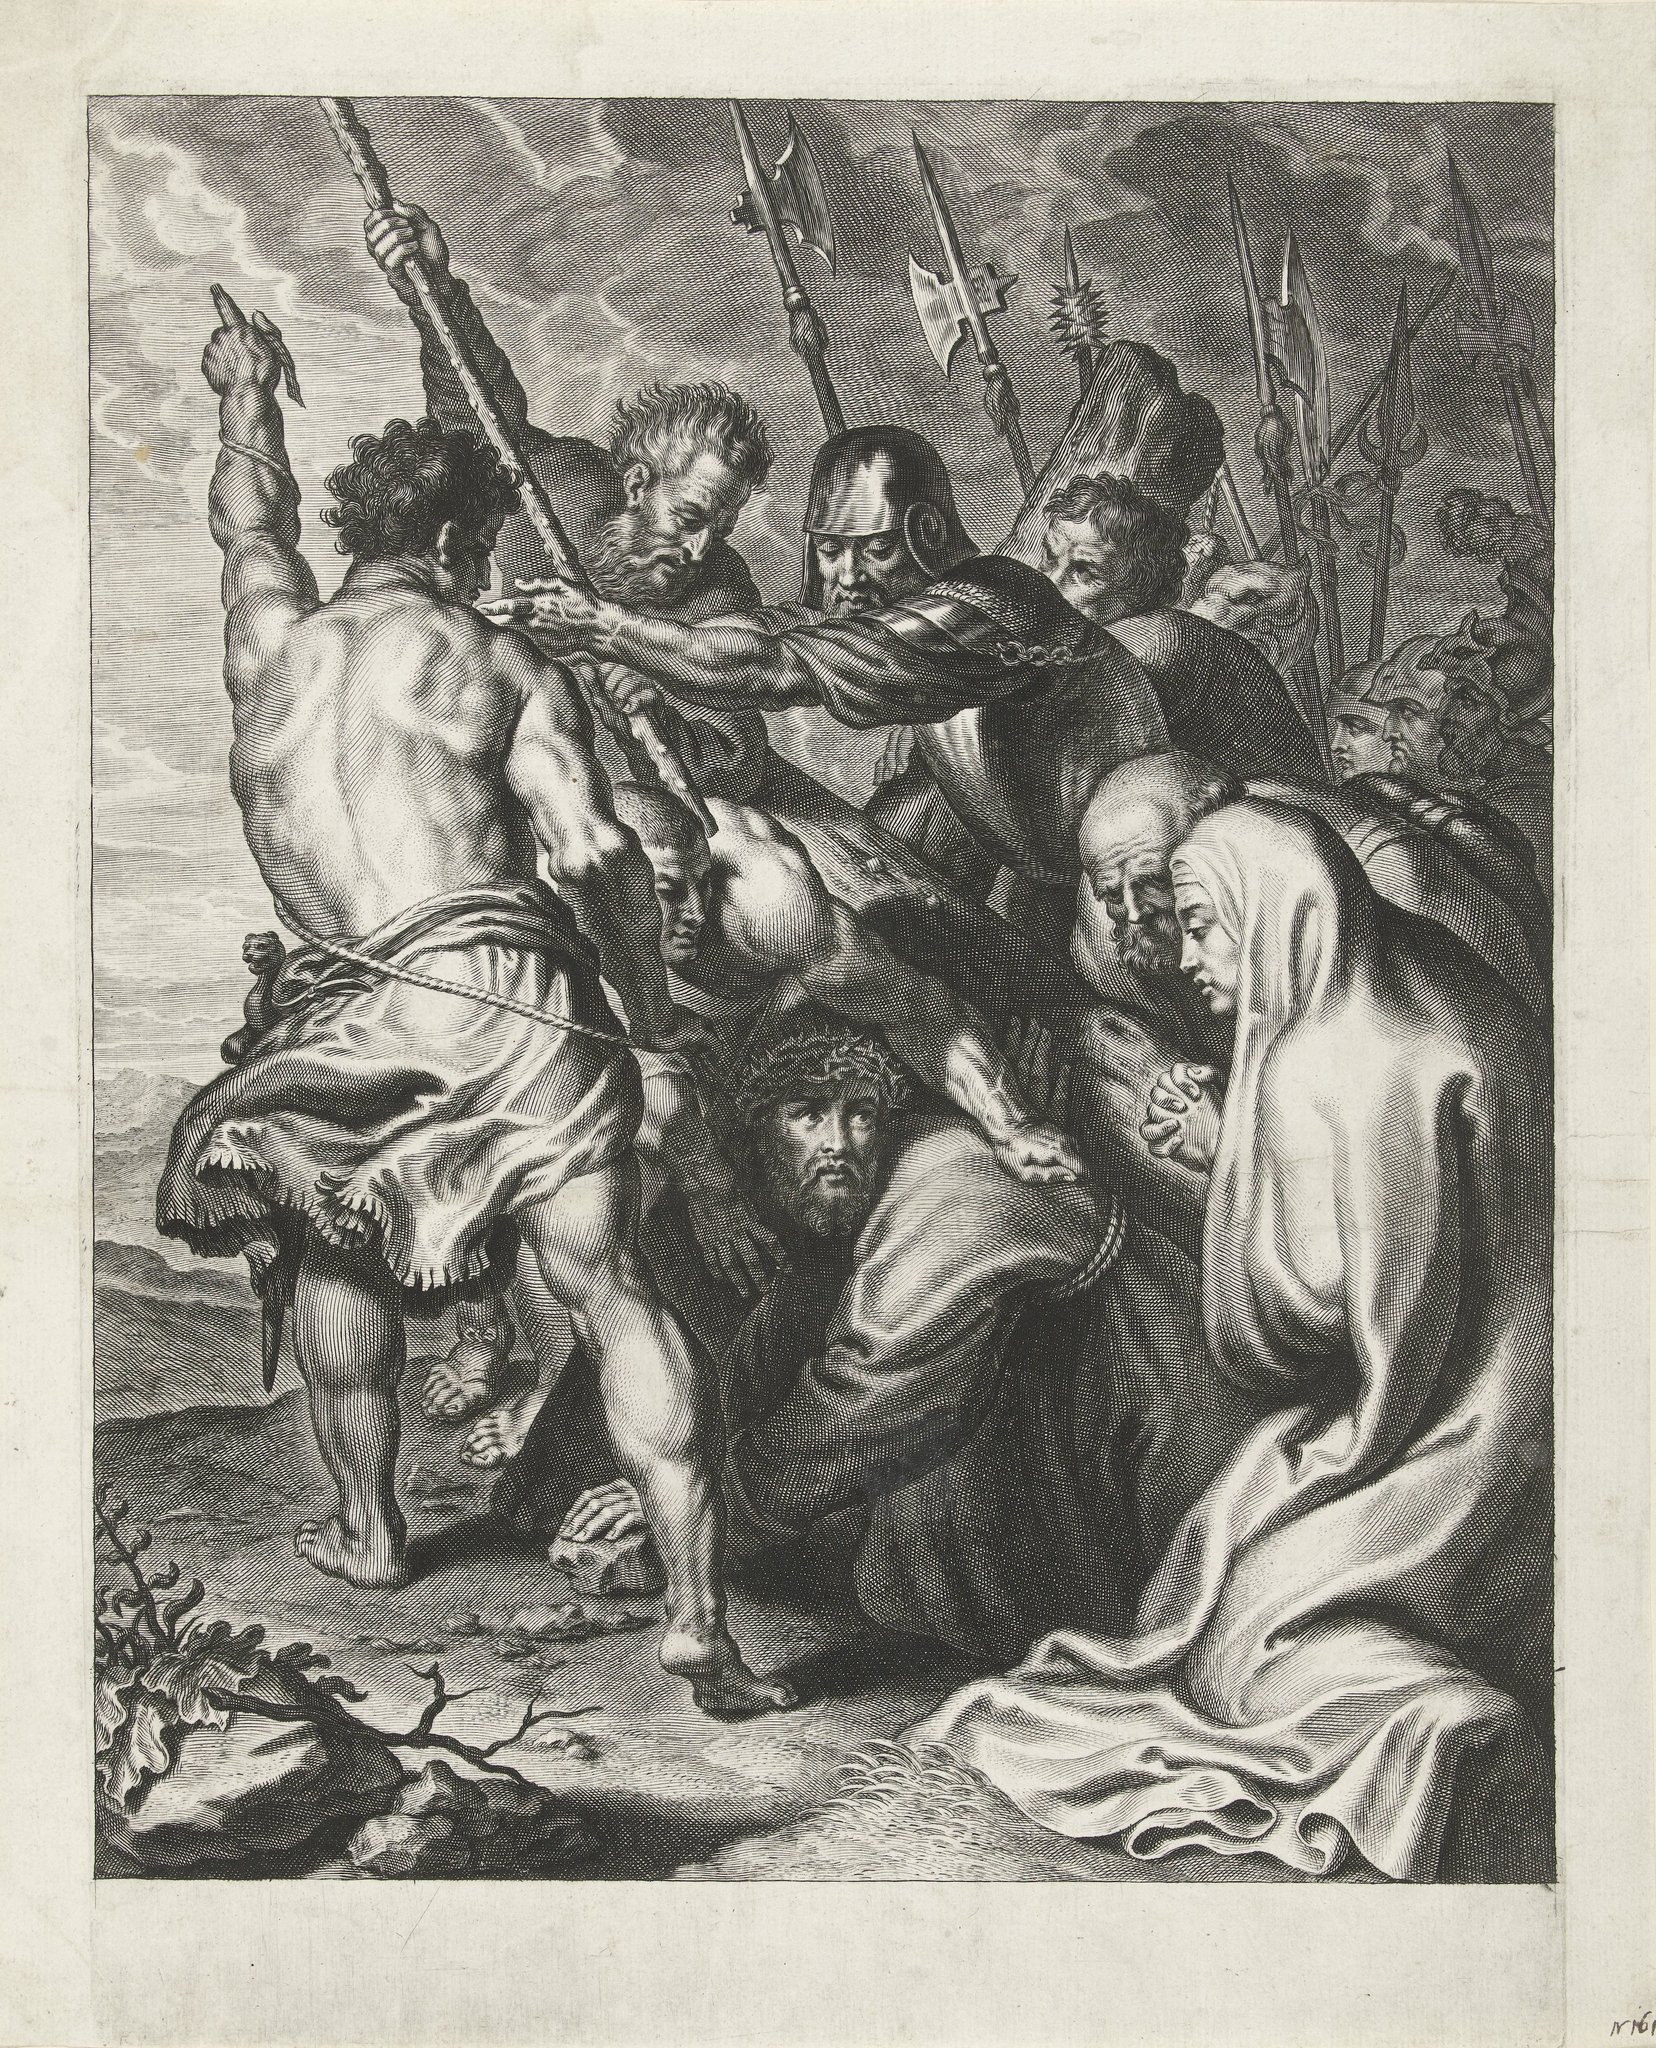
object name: print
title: Kruisdraging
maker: cornelis galle (i)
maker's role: print maker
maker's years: 1576-1650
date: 1586-1650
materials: paper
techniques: engraving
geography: antwerp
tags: christ collapsing ~ carrying of the cross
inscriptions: collector's mark: Lugt 240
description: Omringd door een menigte draagt Christus het kruis naar Golgotha. Hij steunt op handen en knieën en dreigt te bezwijken onder zijn last. Soldaten drijven hem aan en trekken hem verder. Naast het kruis knielt Maria met gevouwen handen, Simon van Cyrene helpt Christus zijn last te dragen.